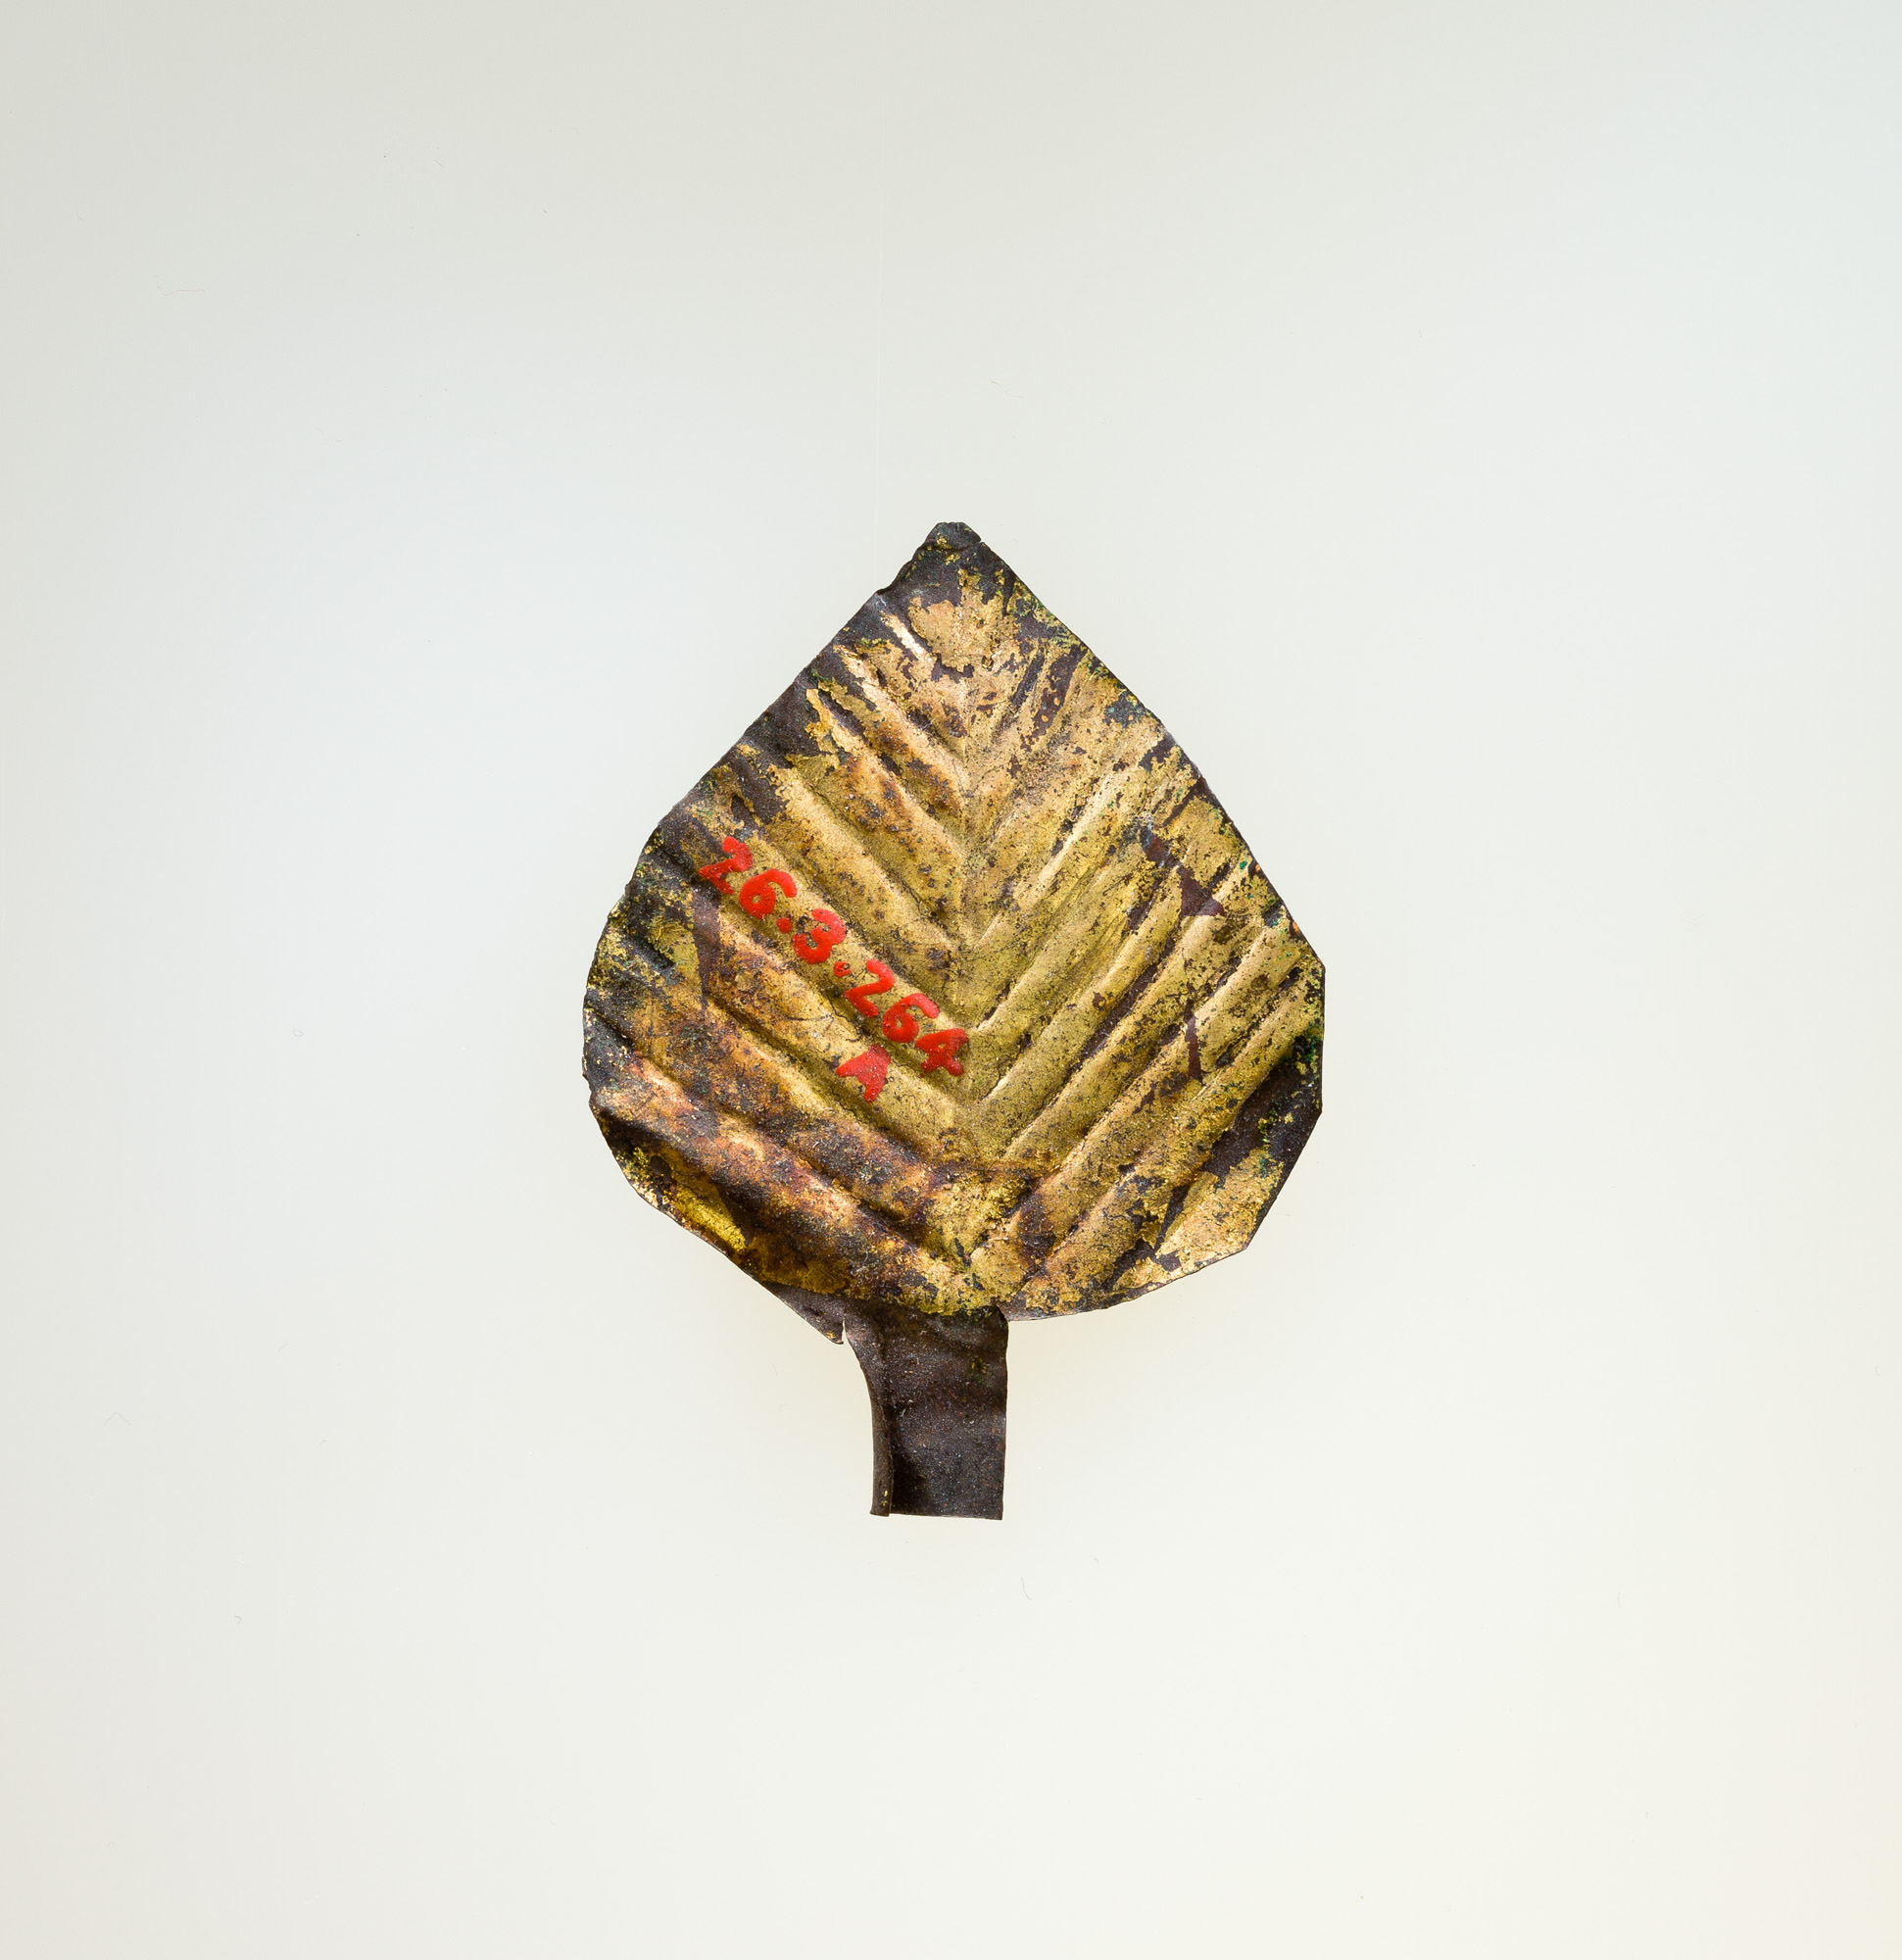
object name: wreath leaf, gilded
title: Three gilded leaves from a wreath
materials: copper alloy, gold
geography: egypt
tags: leaves